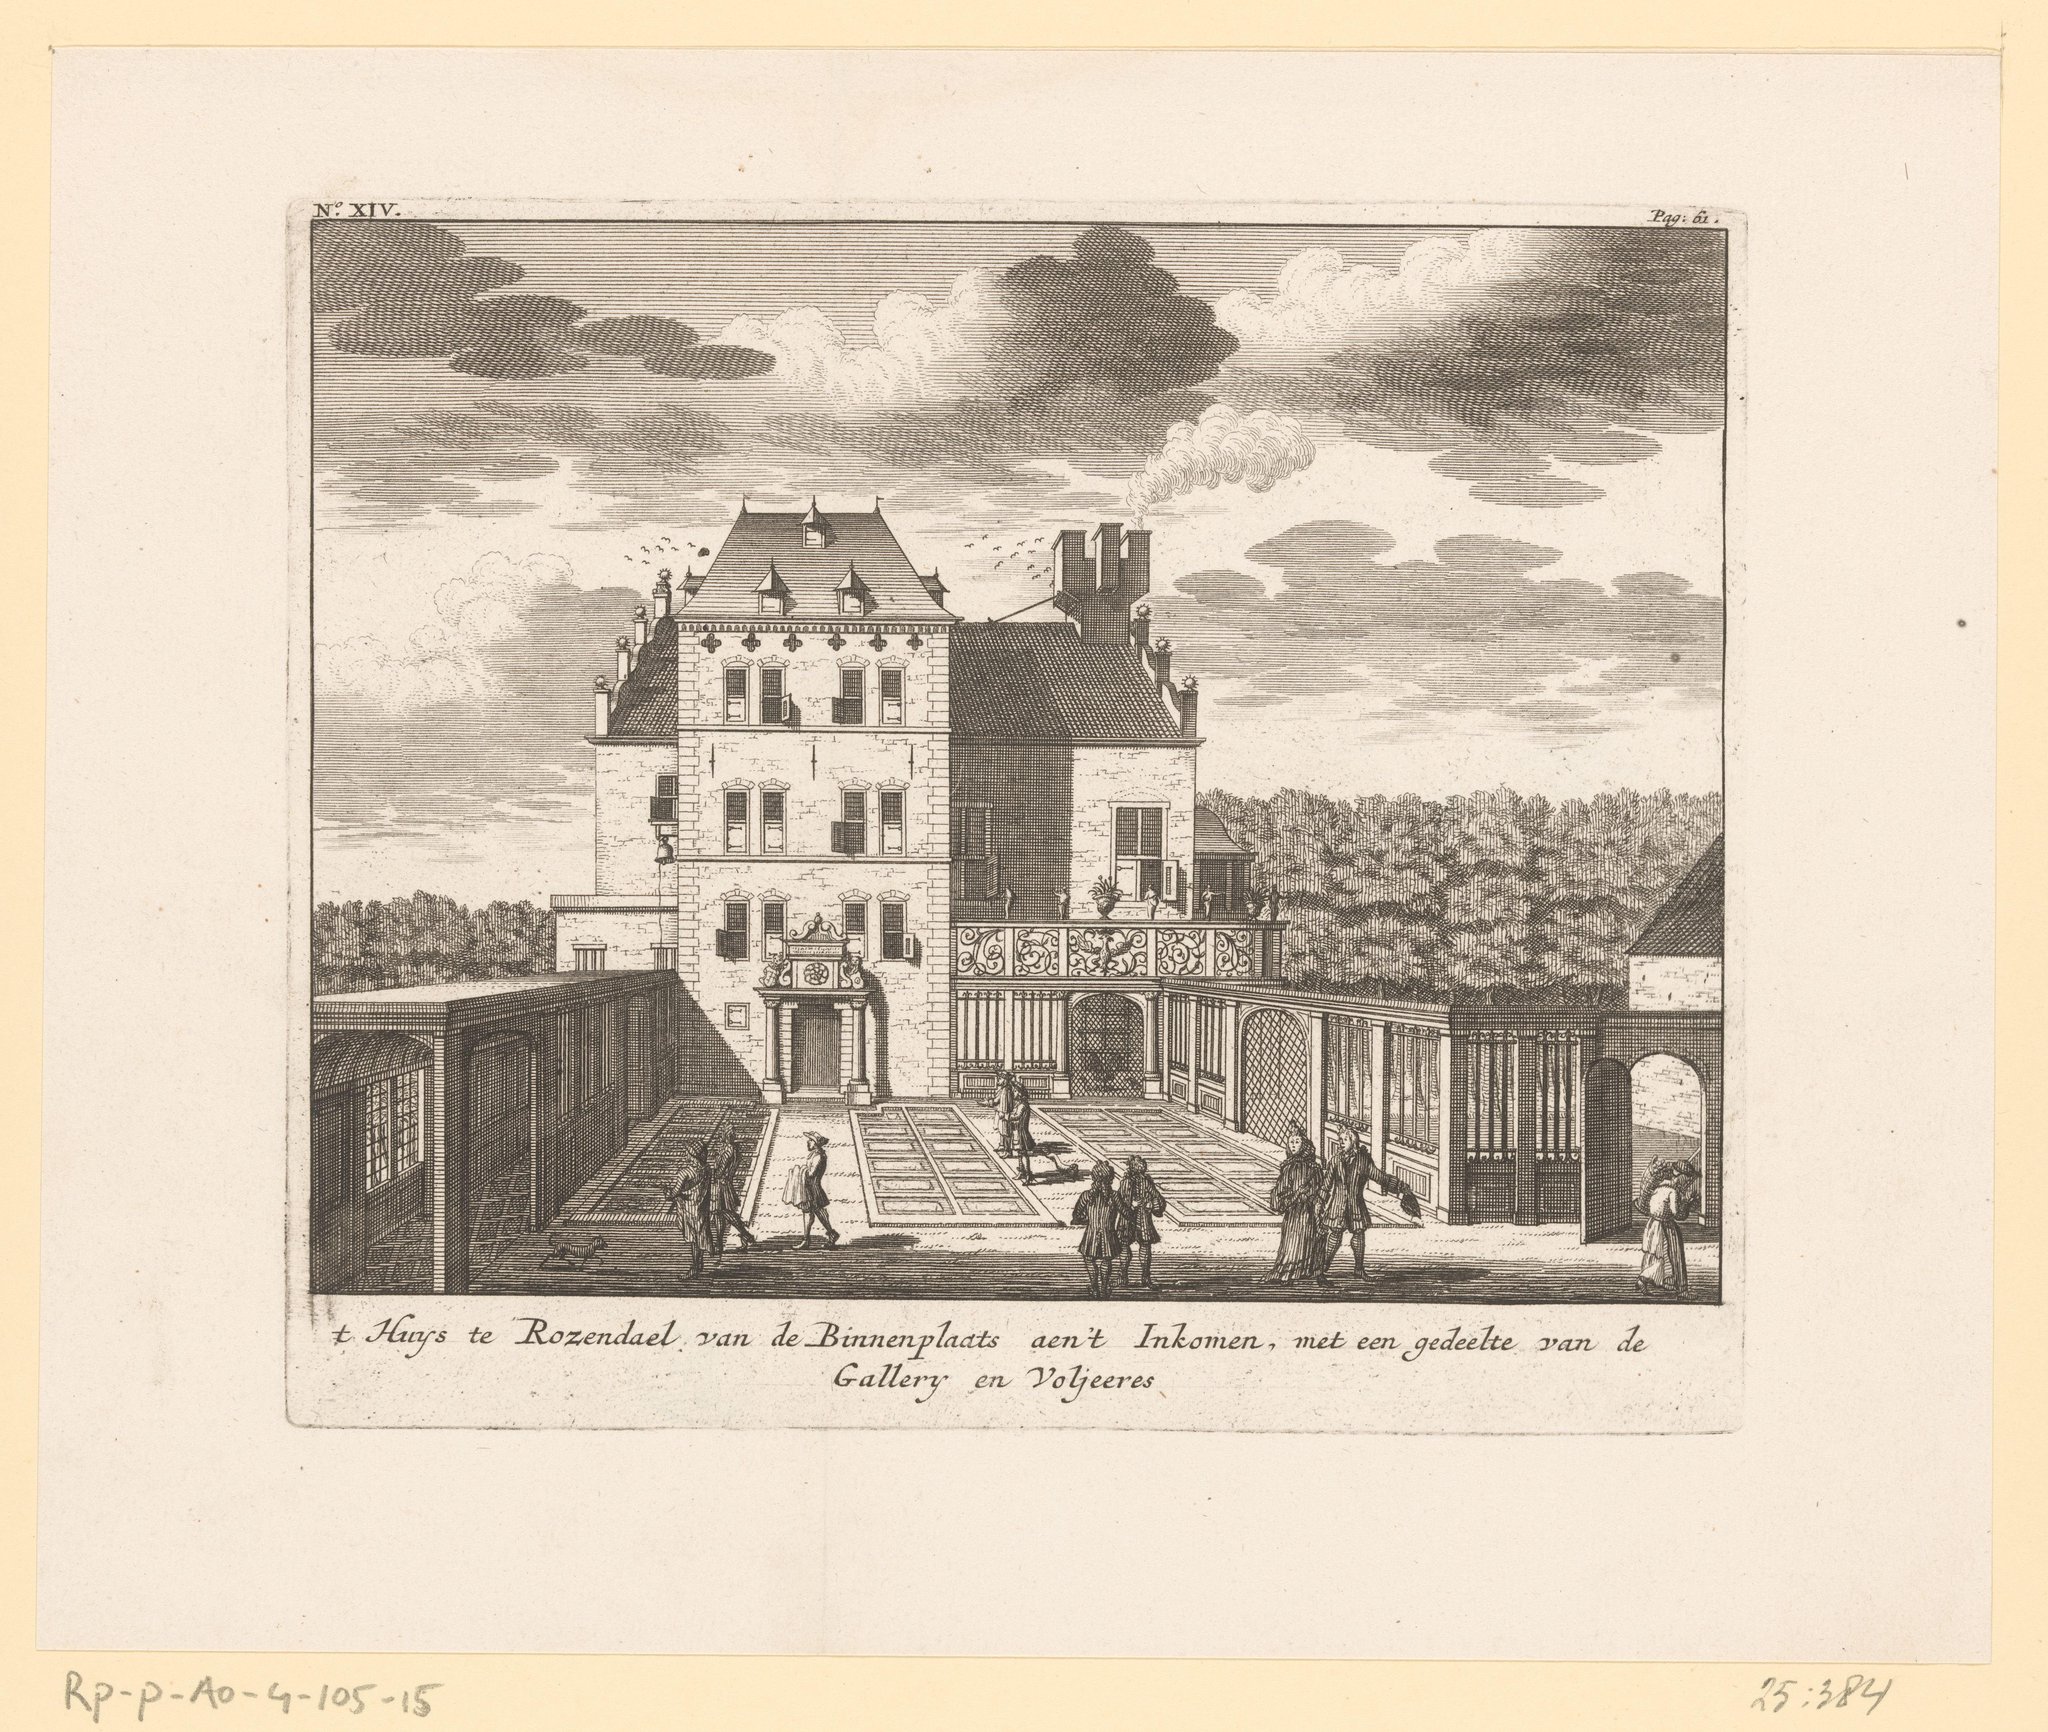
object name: book illustration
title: t Huys te Rozendael van de binnenplaats aen 't inkomen, met een gedeelte (...)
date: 1718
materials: paper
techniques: engraving, etching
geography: amsterdam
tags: castle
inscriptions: collector's mark: Lugt 195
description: Prent ook gebruikt in: Outrein, Johannes d’. Wegwyser door de heerlykheid Roosendaal ofte, de Roosendaalsche vermakelykheden. 3e druk. Amsterdam: Gerard van Keulen, 1718.